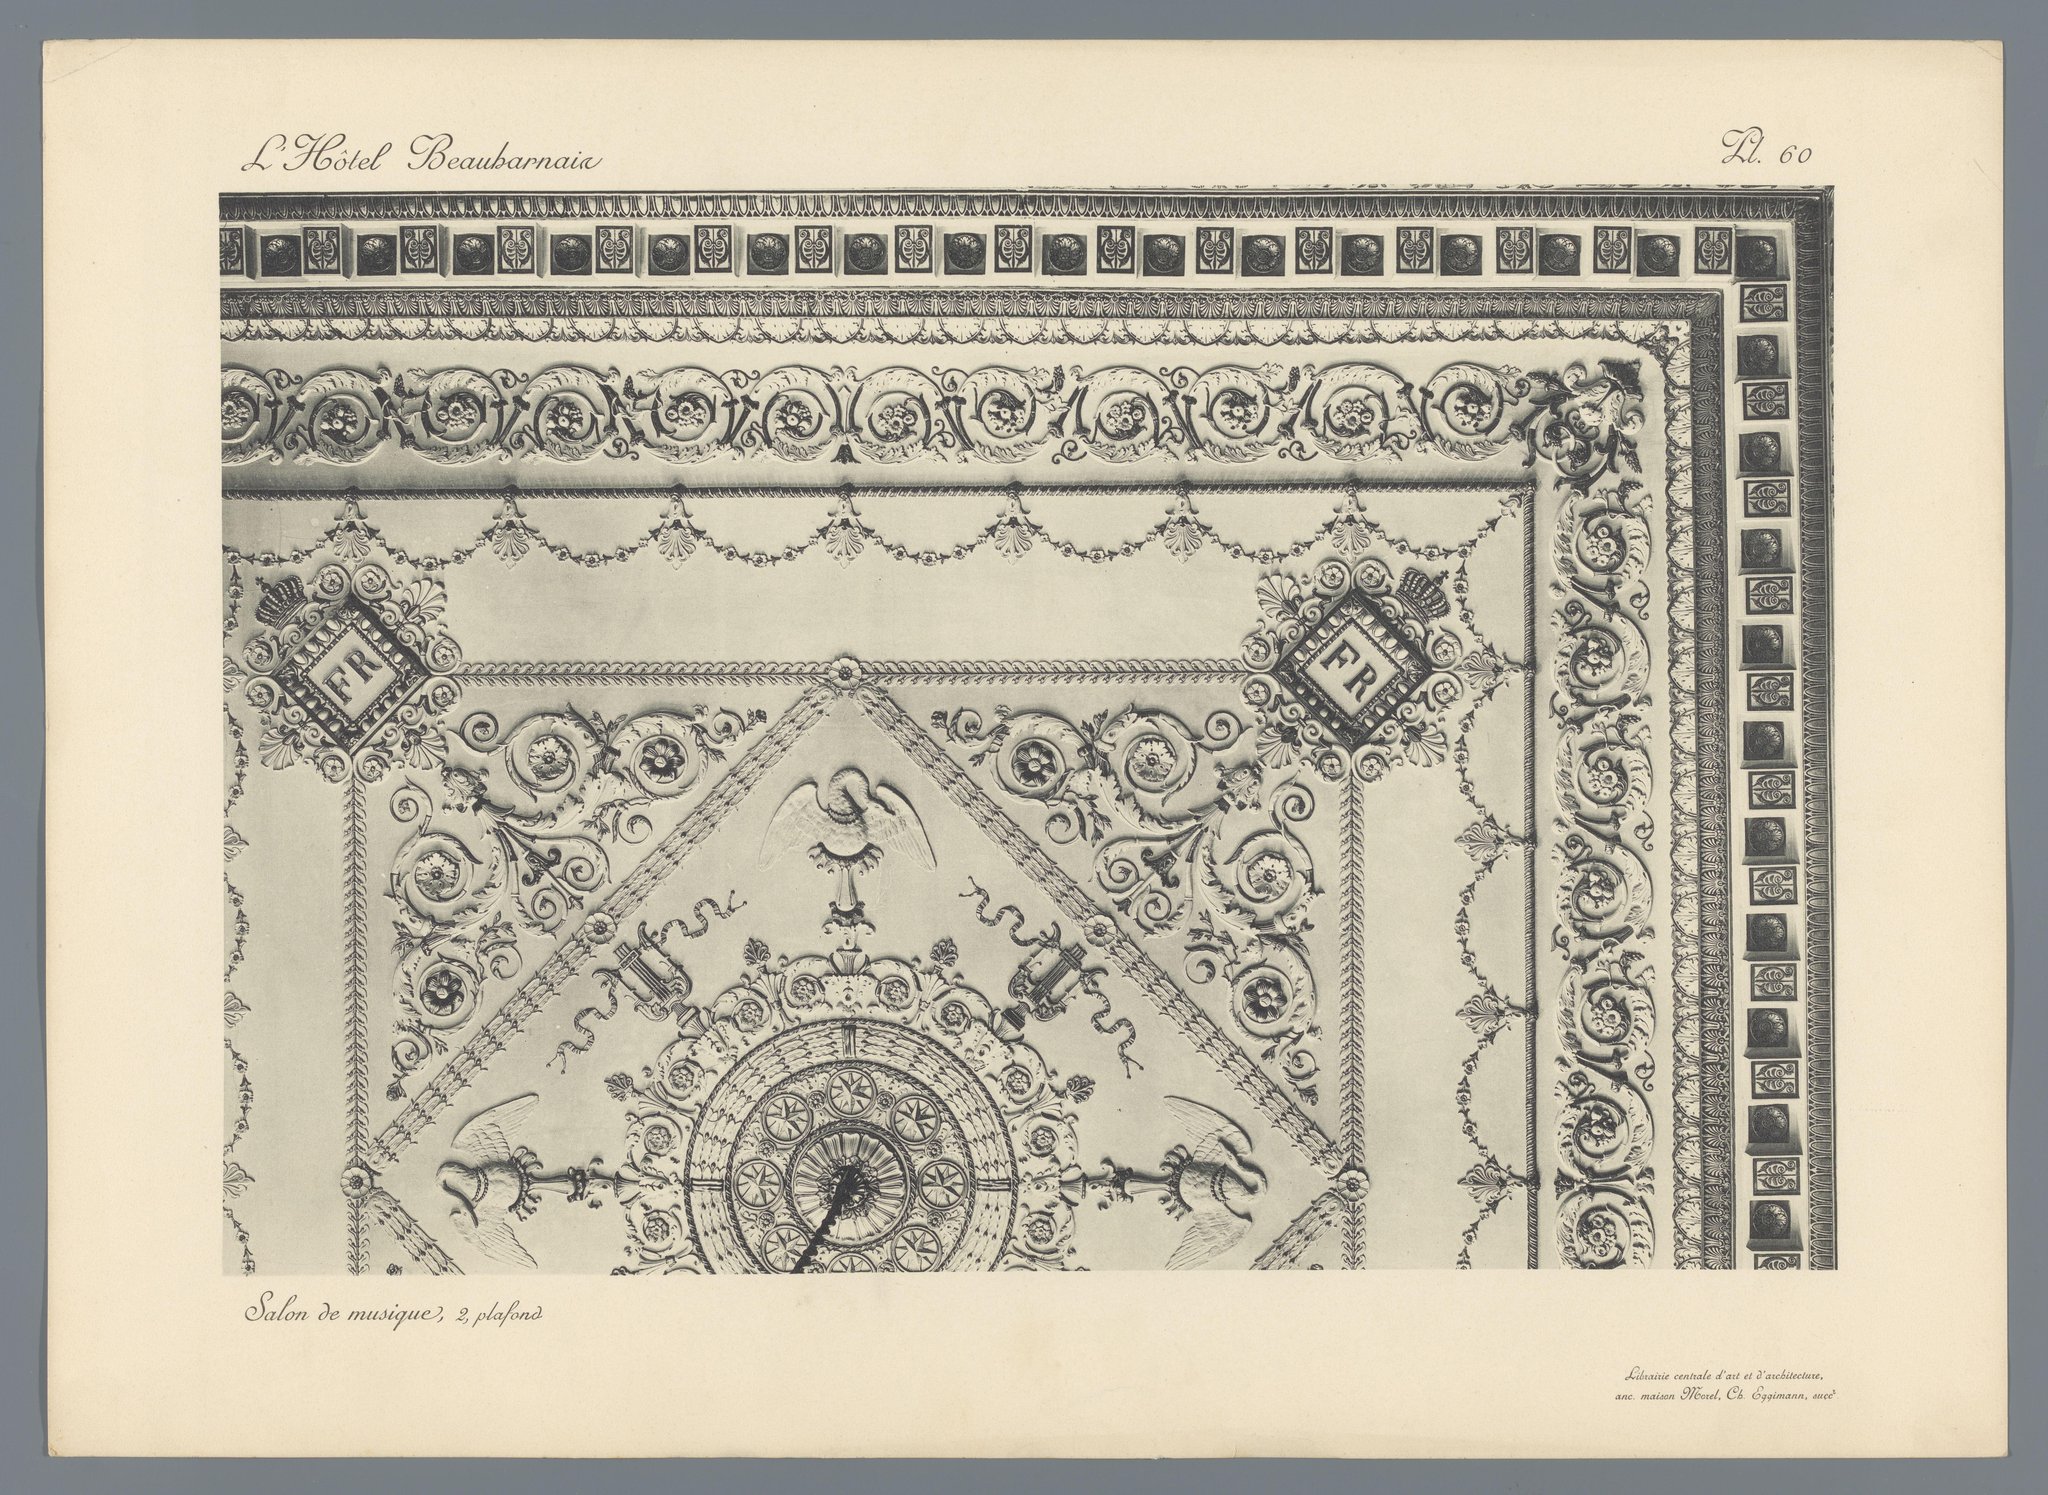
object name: photomechanical print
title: Gezicht op het gedecoreerde plafond van de Salon de musique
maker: Anonymous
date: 1875-1930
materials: paper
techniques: photograph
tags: (decorated) ceiling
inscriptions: number: ‘60’, inscription: ‘2, plafond’, collector's mark: ‘Rijks normaalschool voor teekenonderwijzers Amsterdam’